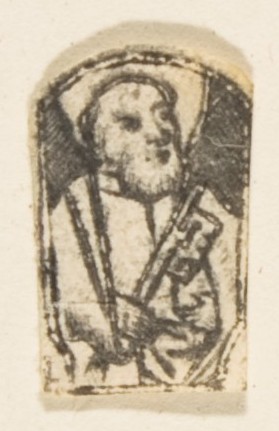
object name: print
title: St. Peter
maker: anonymous, german, 15th century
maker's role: artist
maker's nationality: german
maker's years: 1400-1500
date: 1401-1500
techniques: woodcut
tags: saint peter